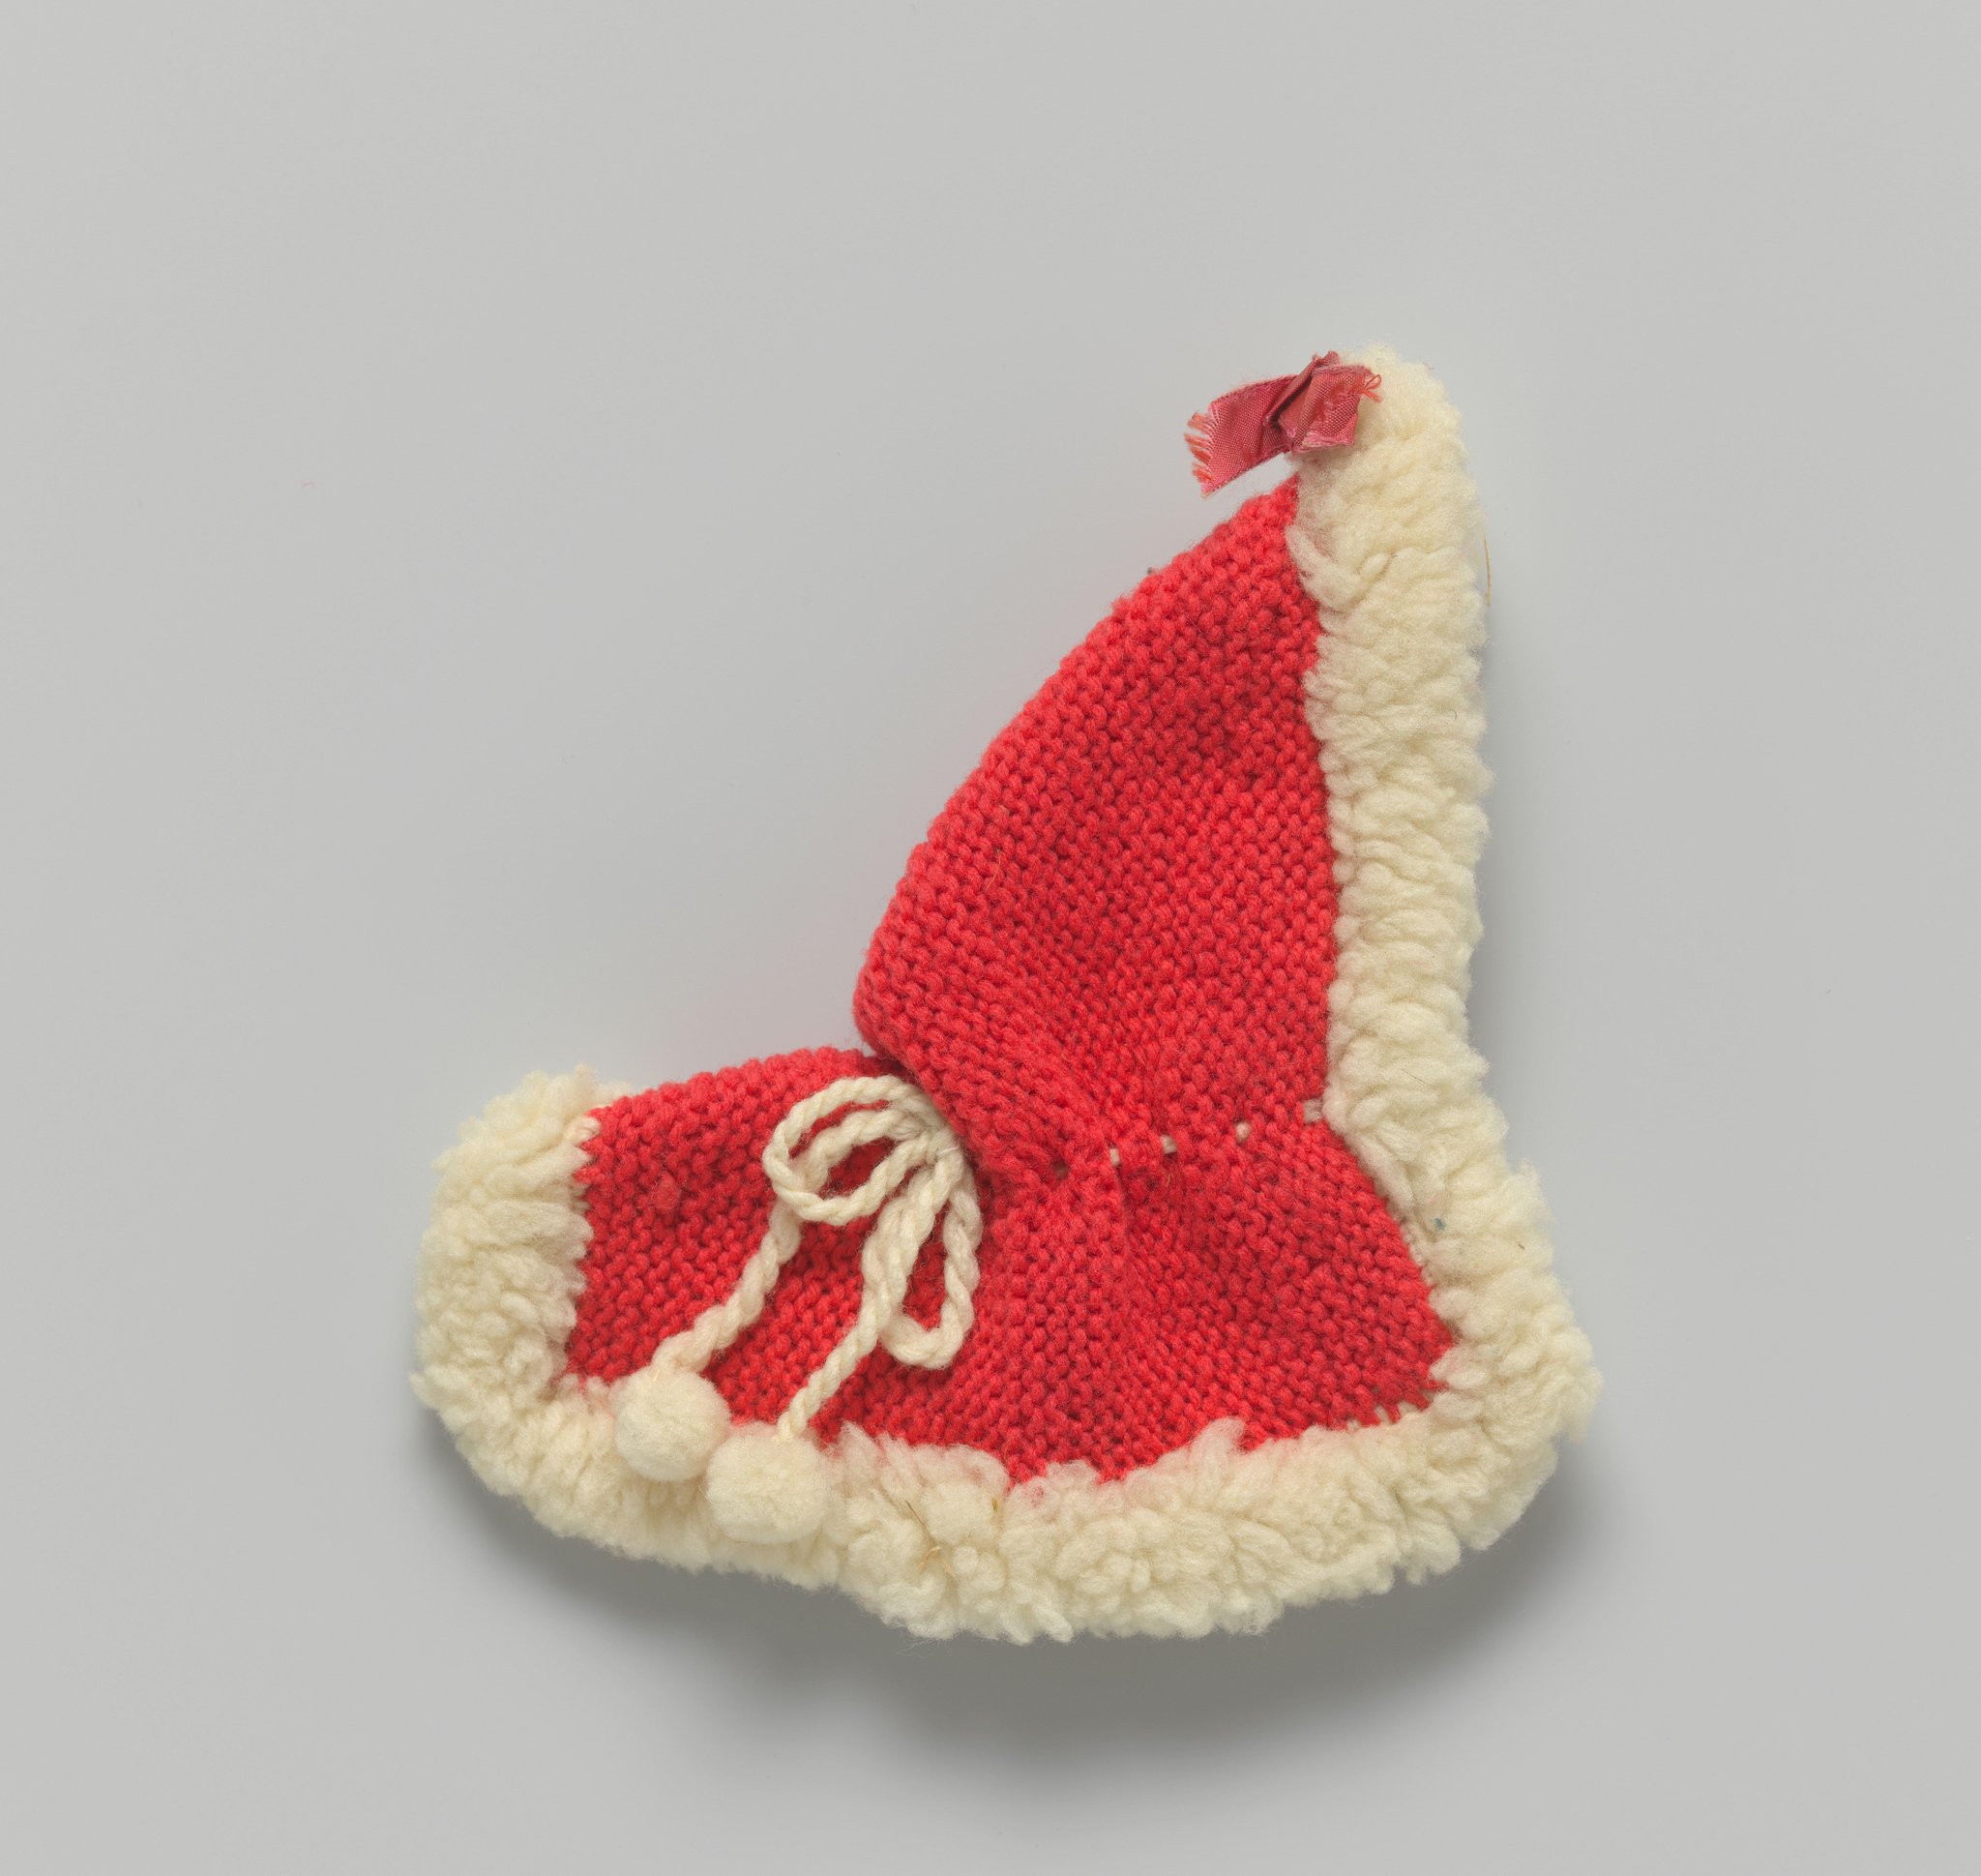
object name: doll's clothing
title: Gebreide rode muts afgezet met wite rand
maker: Anonymous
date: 1850-1920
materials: textile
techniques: knitting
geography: netherlands